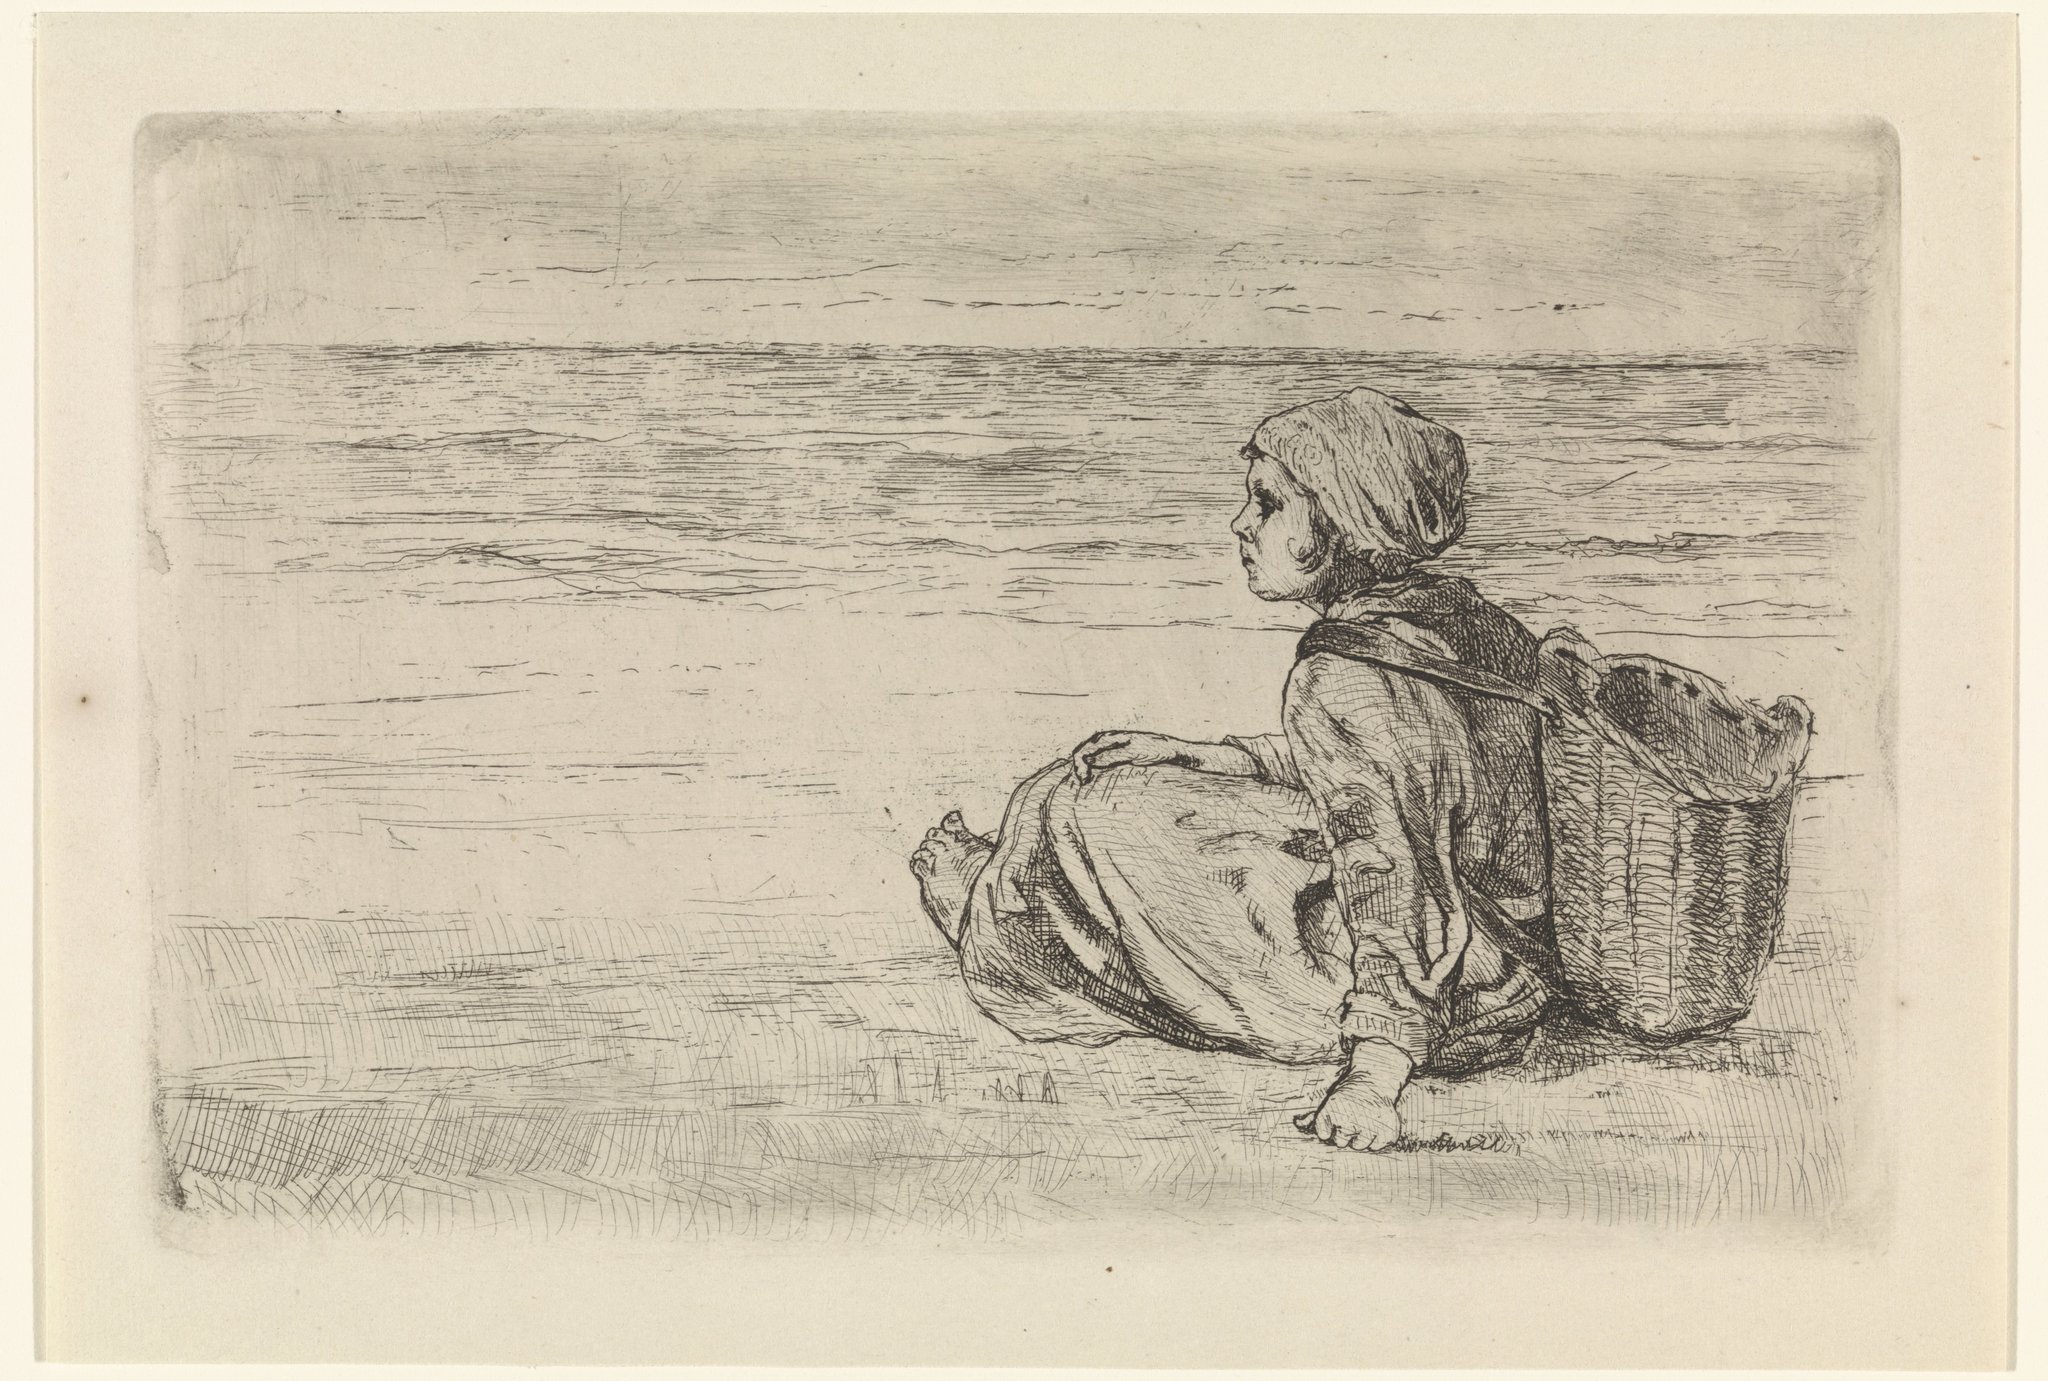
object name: print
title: Meisje aan zee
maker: jozef israëls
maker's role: draughtsman, painter, print maker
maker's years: 1824-1911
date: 1835-1910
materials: paper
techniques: etching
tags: sea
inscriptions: collector's mark: Lugt 2228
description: Meisje met muts en mand op de rug, zittend aan zee.